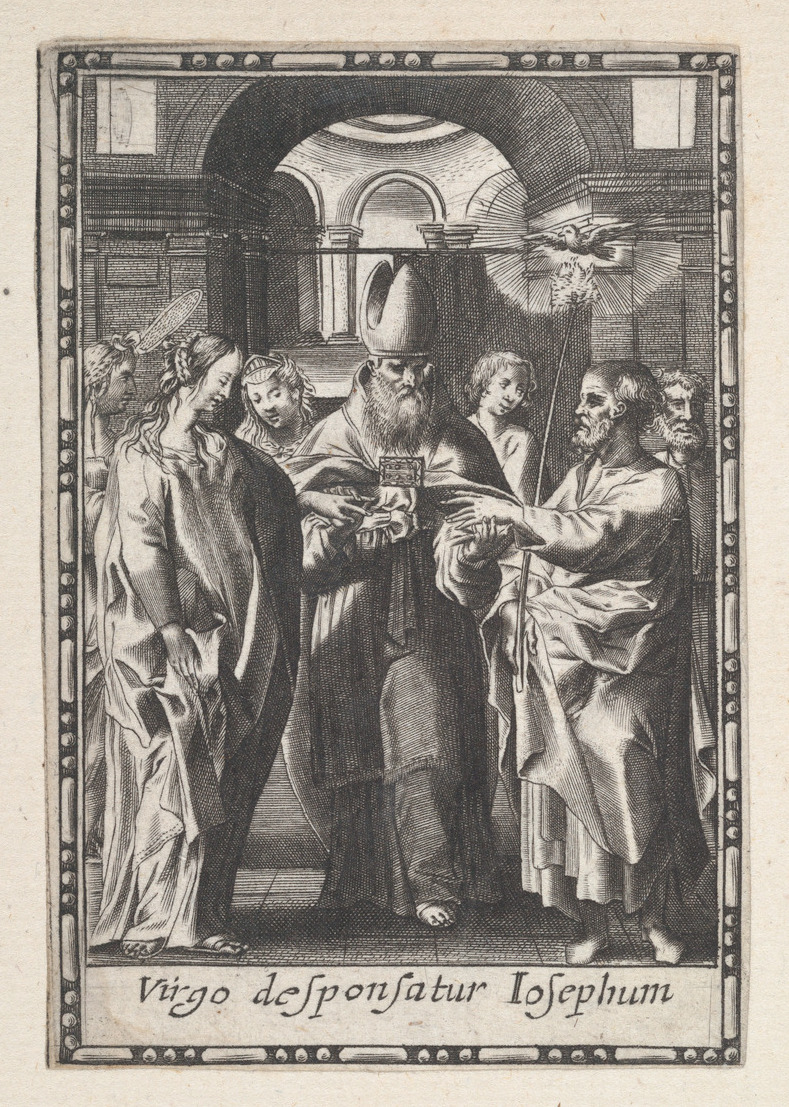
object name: print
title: Marriage of the Virgin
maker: Anonymous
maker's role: artist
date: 1590-1620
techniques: engraving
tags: virgin mary